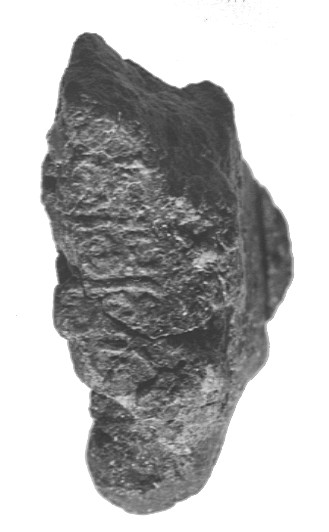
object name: sealing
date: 2030-1640 BCE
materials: clay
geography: egypt